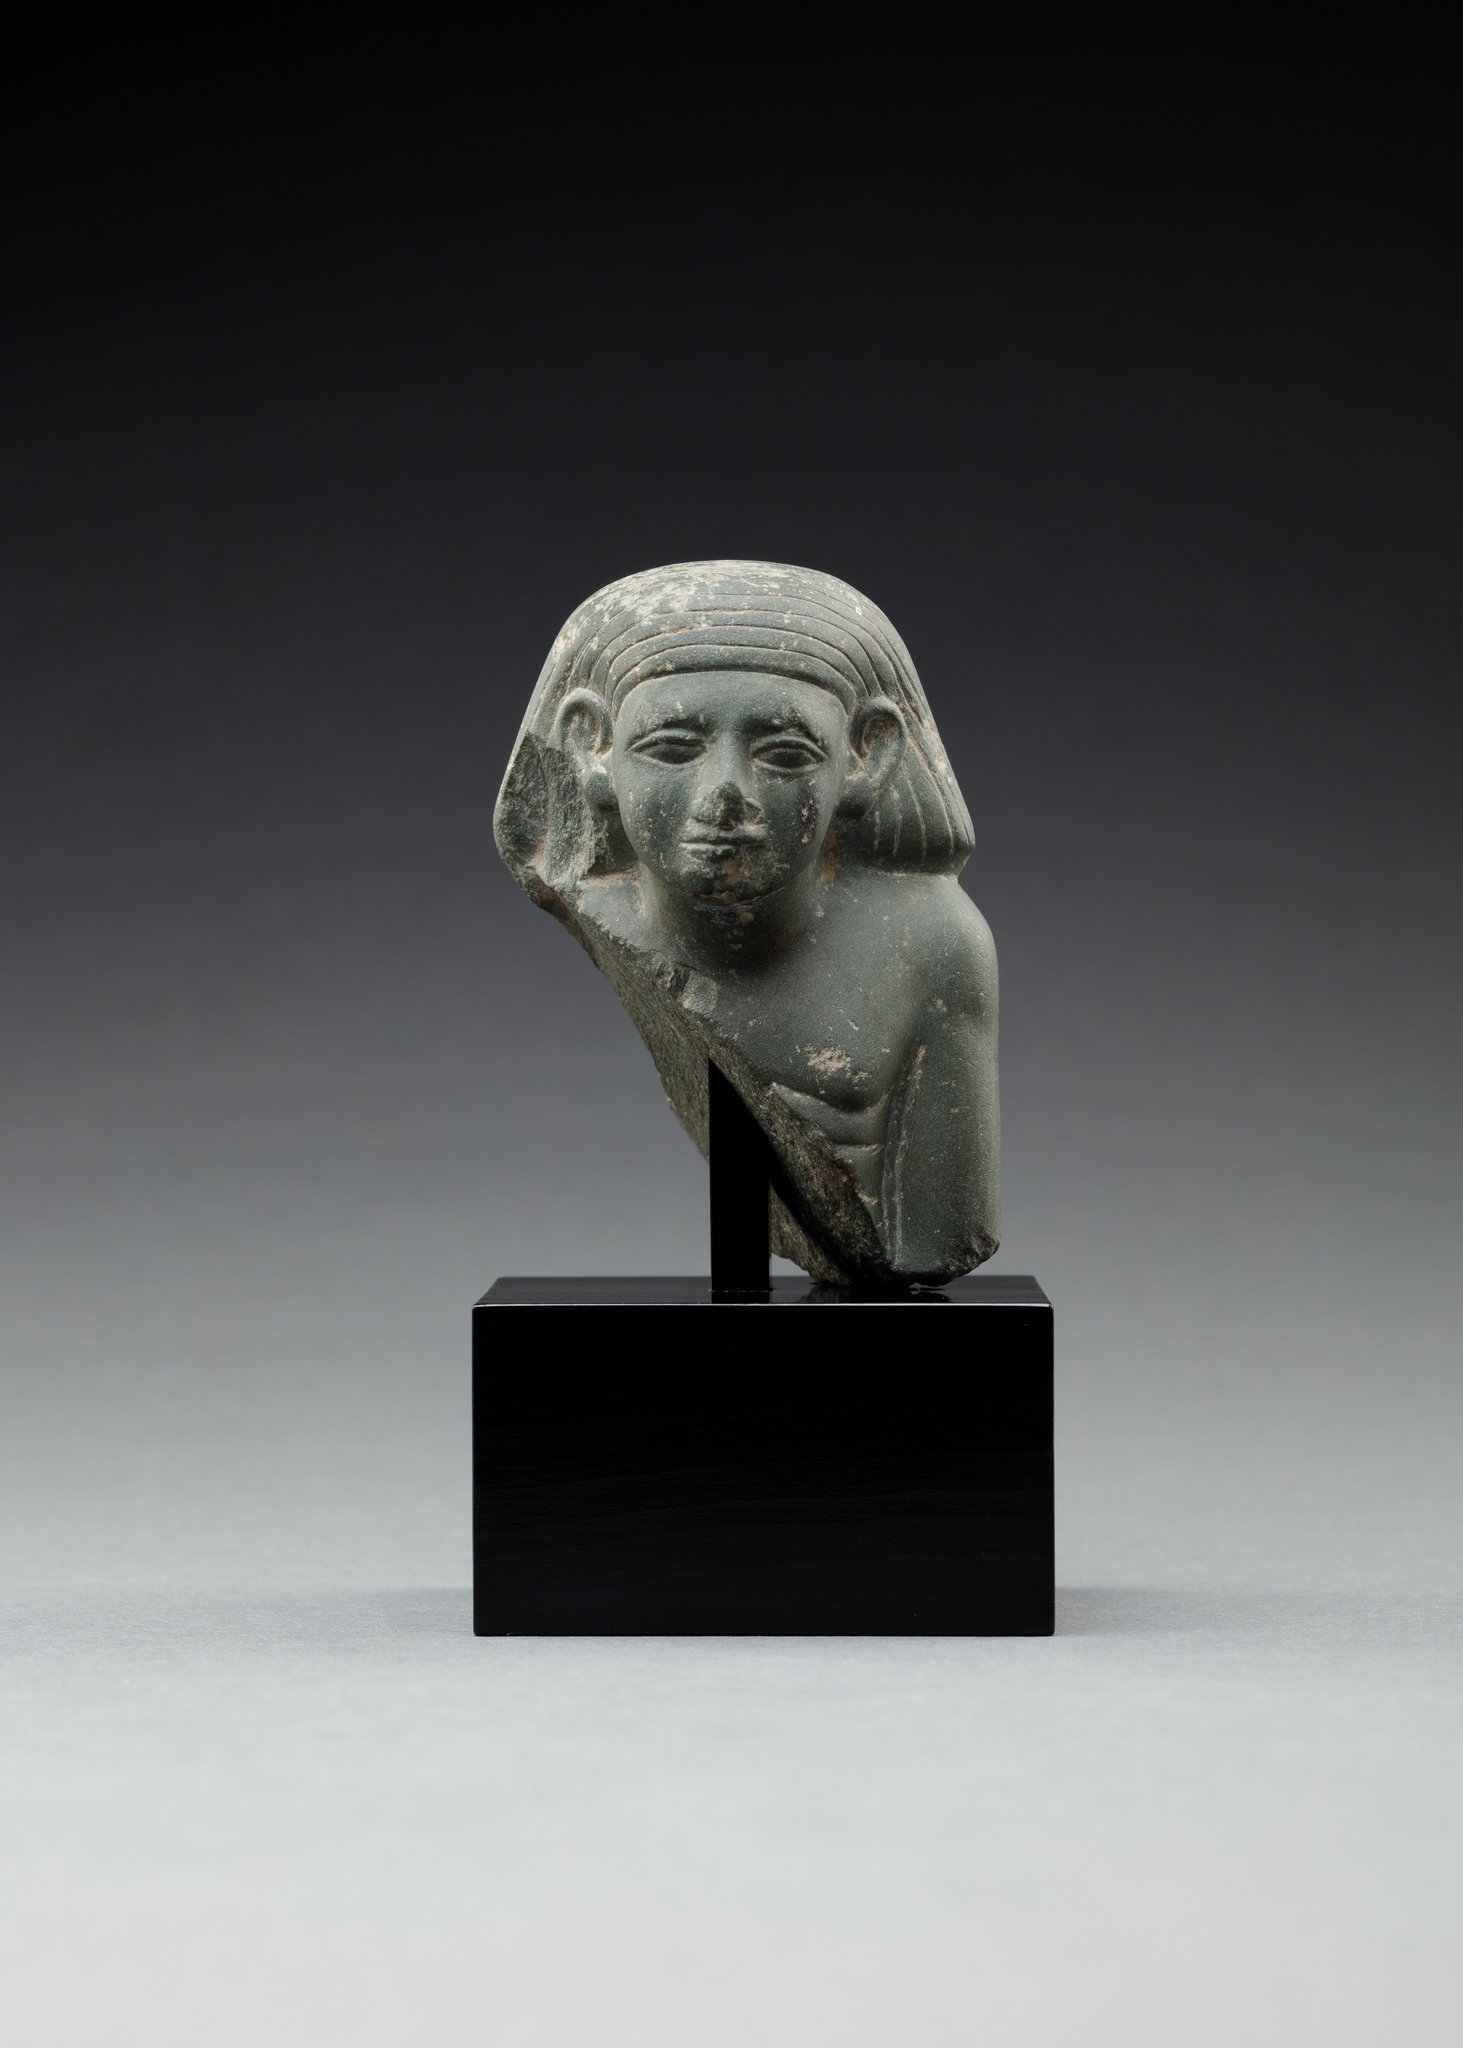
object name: upper part of a male seated figure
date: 1800-1650 BCE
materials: stone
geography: egypt